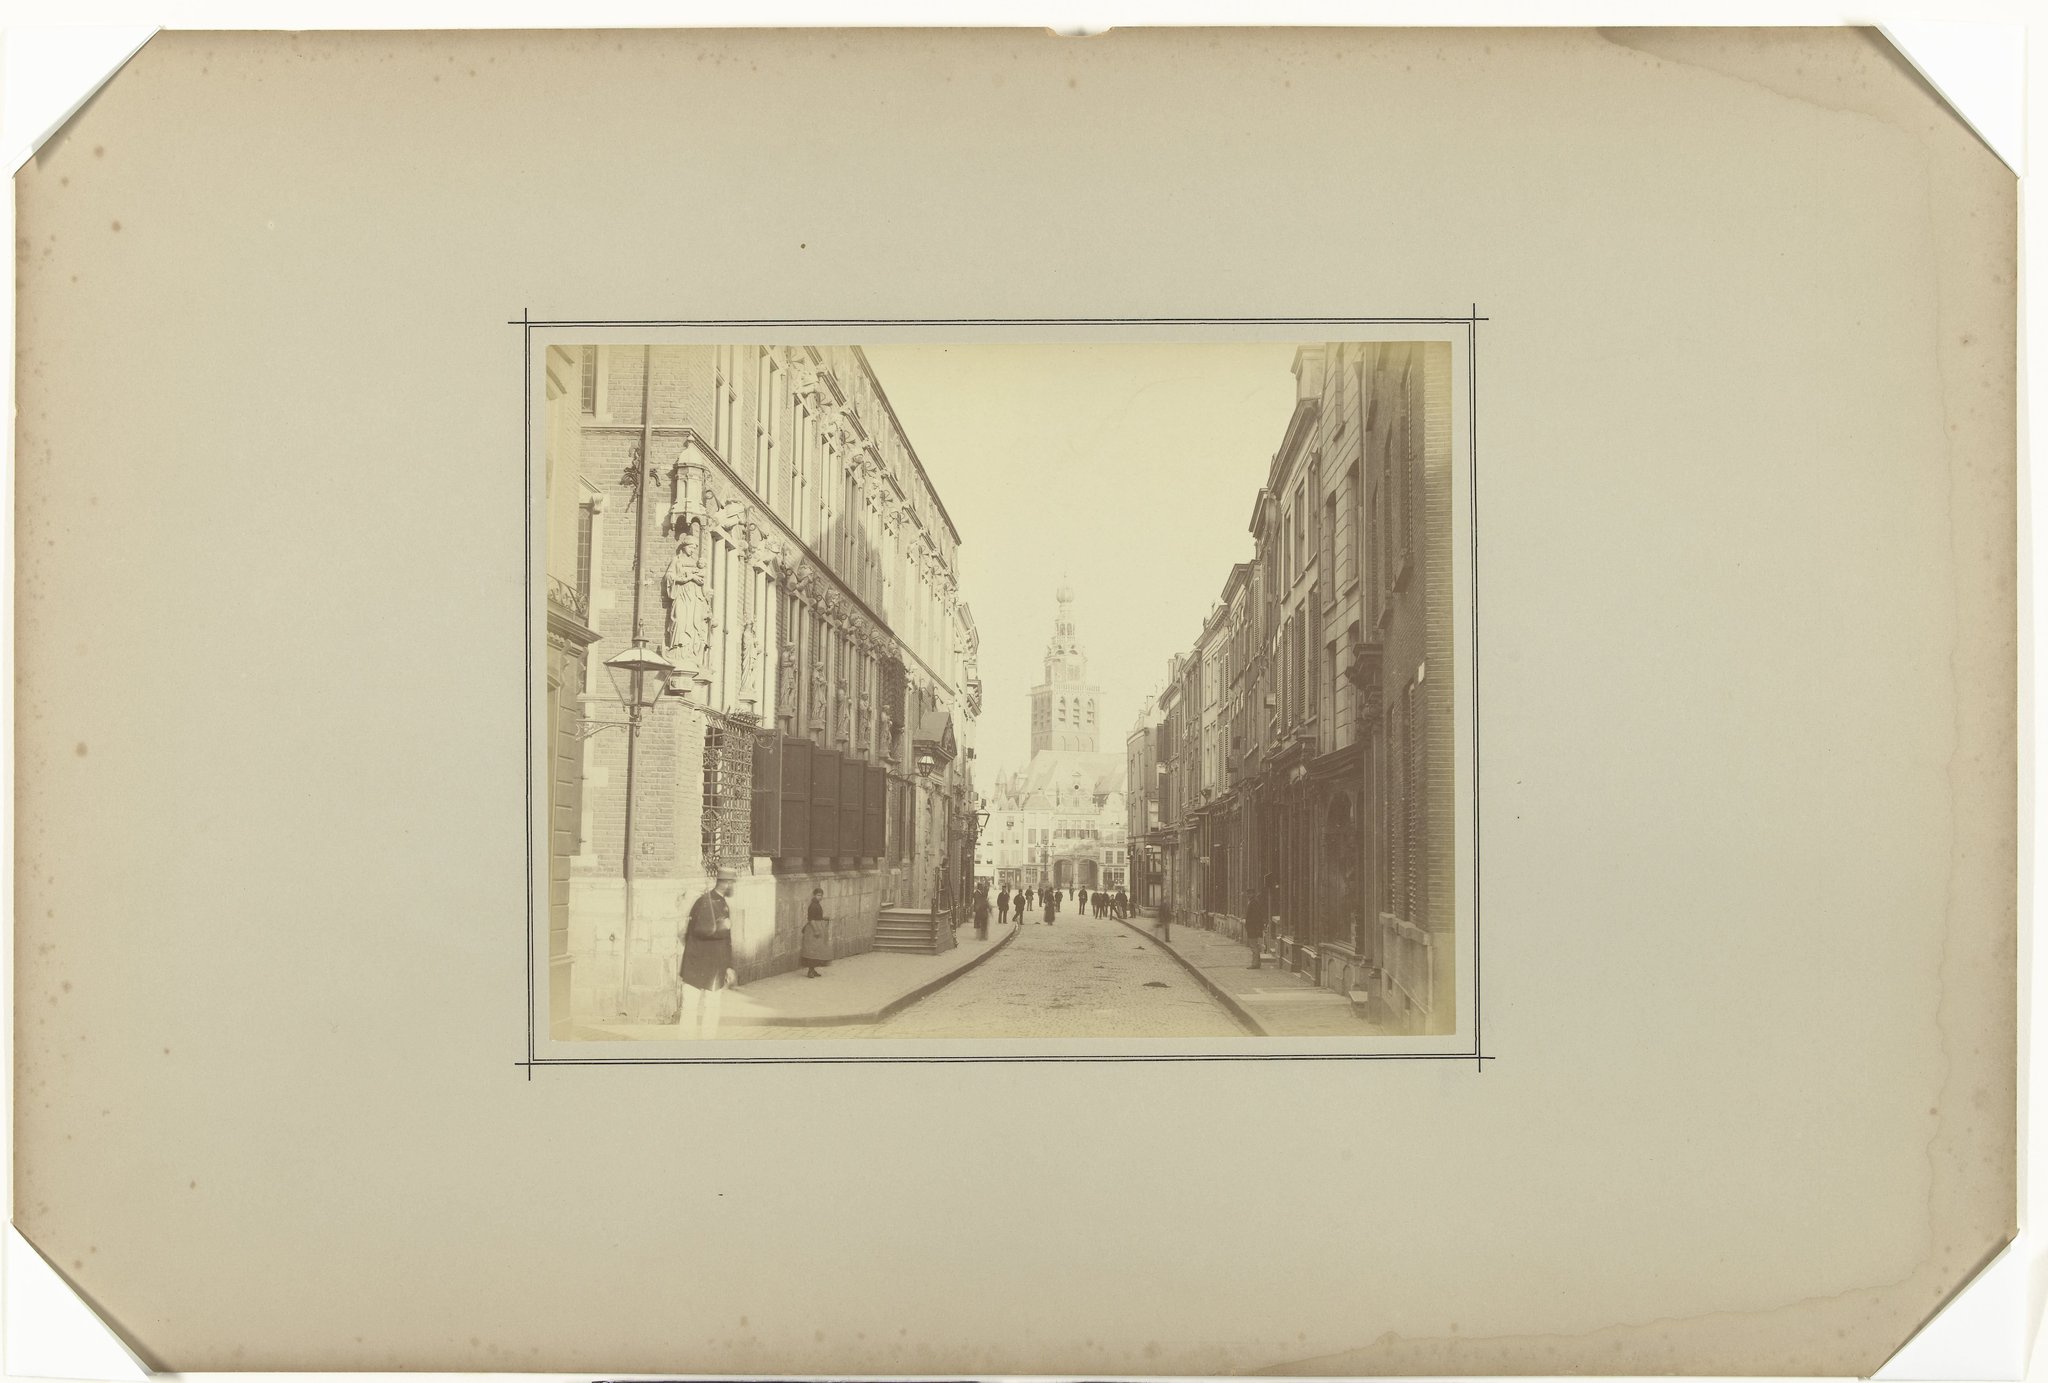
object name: photograph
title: Burchtstraat in Nijmegen, met links het stadhuis en de Grote Markt en de St.-Stevenskerk op de achtergrond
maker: wilhelm ivens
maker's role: fotograaf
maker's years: 1849-1904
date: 1885-1890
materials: cardboard, photographic support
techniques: albumen print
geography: nijmegen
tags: grote markt, sint-stevenskerk